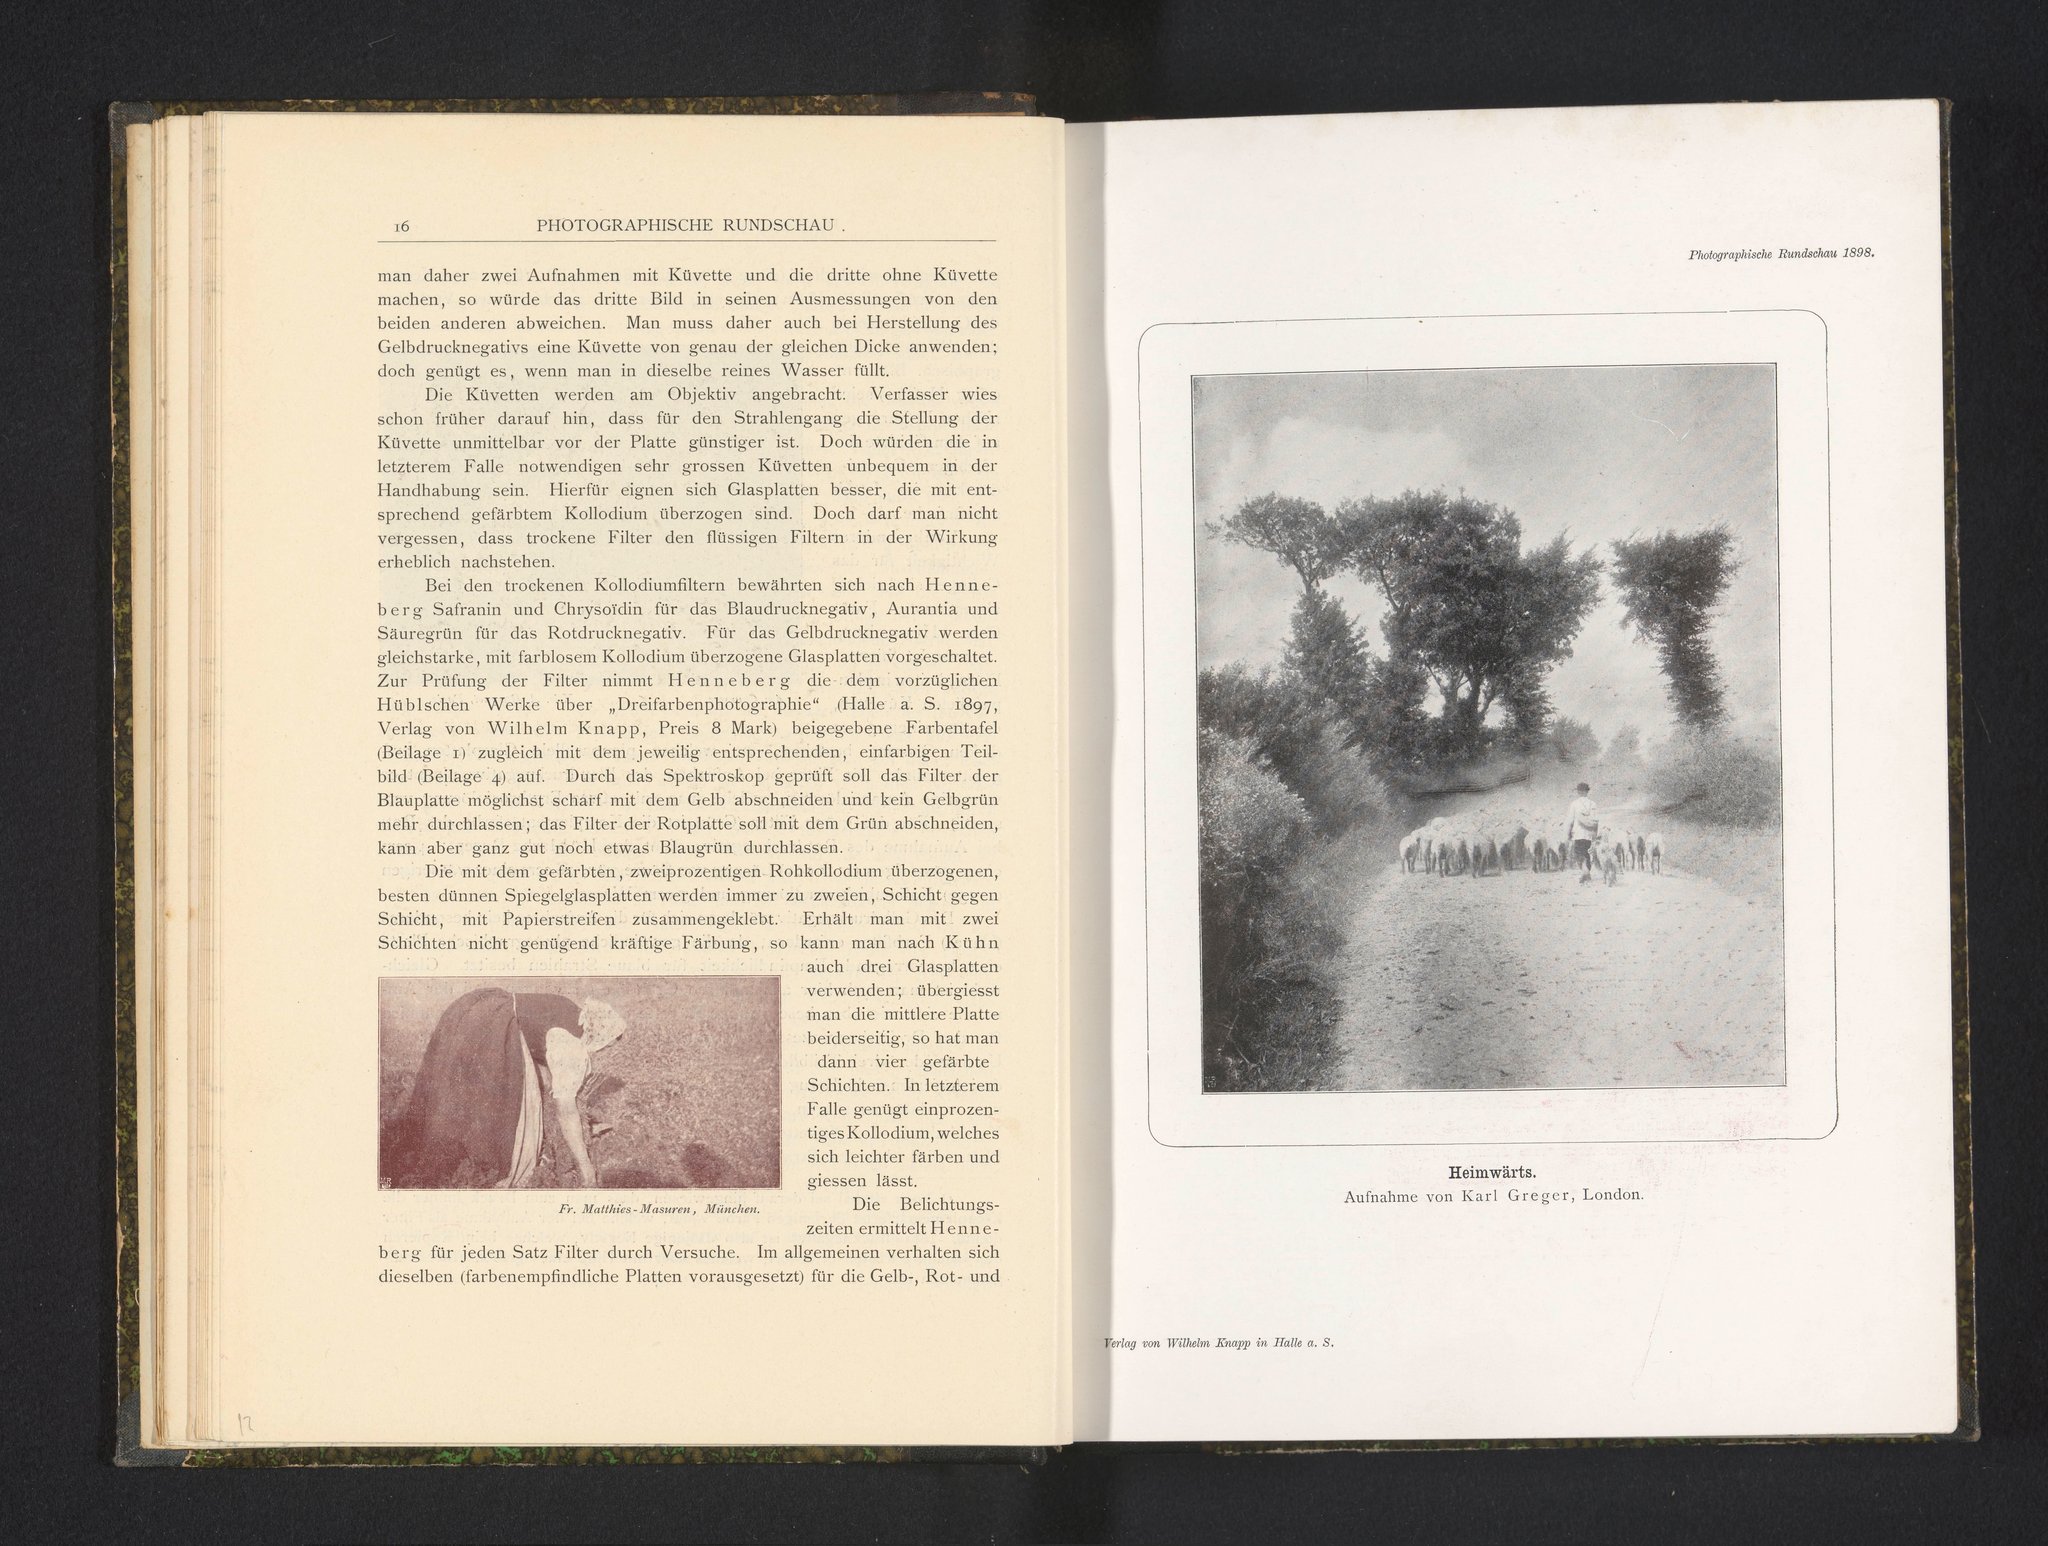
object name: photomechanical print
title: Herder met een kudde schapen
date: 1893-1898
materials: paper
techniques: autotype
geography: london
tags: herding, herdsman, herdswoman, shepherd, shepherdess, cowherd, etc., sheep, herd, flock